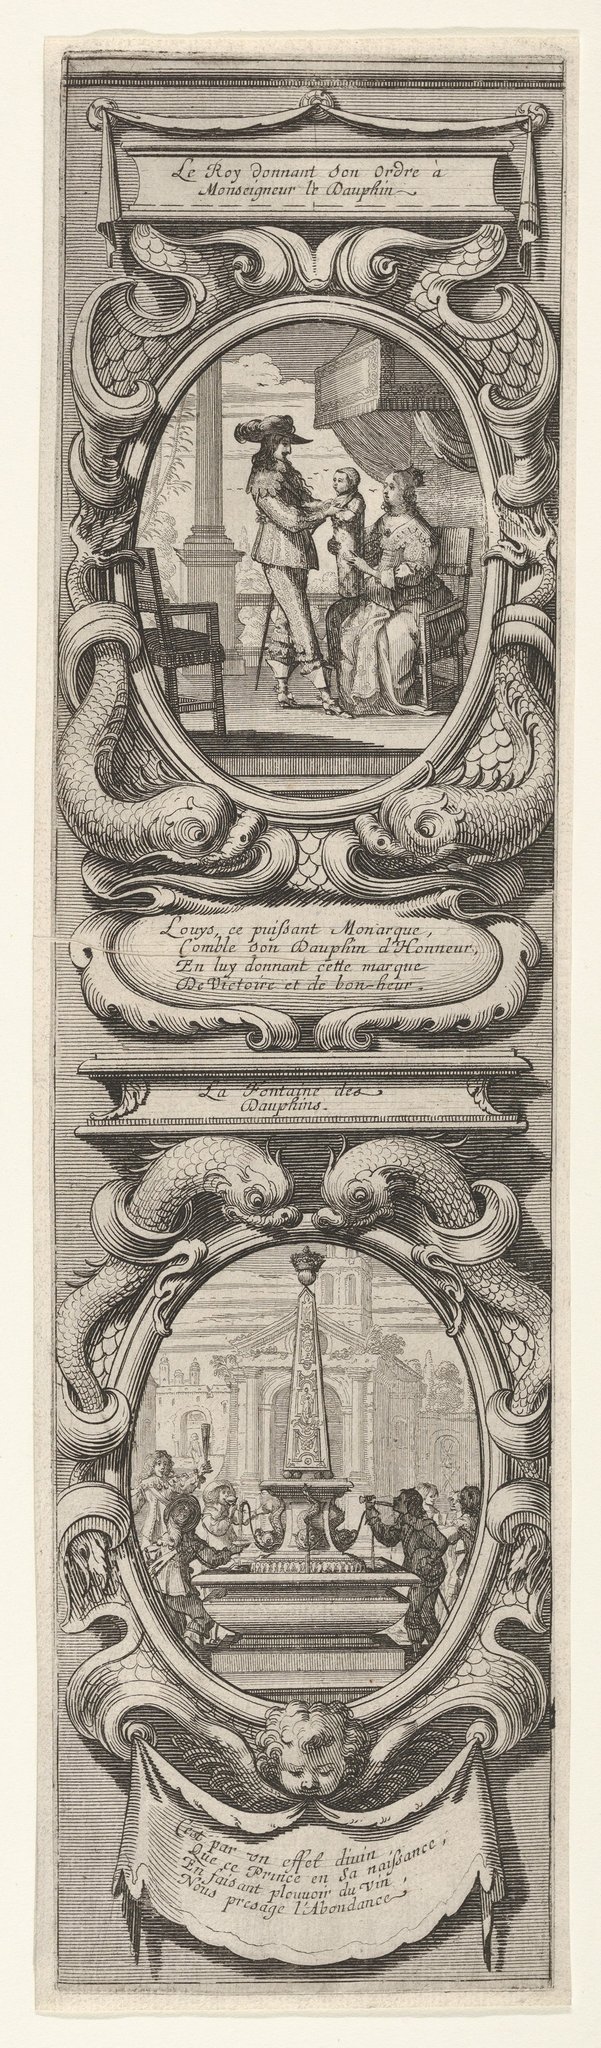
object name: print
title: Allegories in Honor of the Birth of the Dauphin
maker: abraham bosse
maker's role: artist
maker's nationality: french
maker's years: 1602-1676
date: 1638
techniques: etching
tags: satire,men